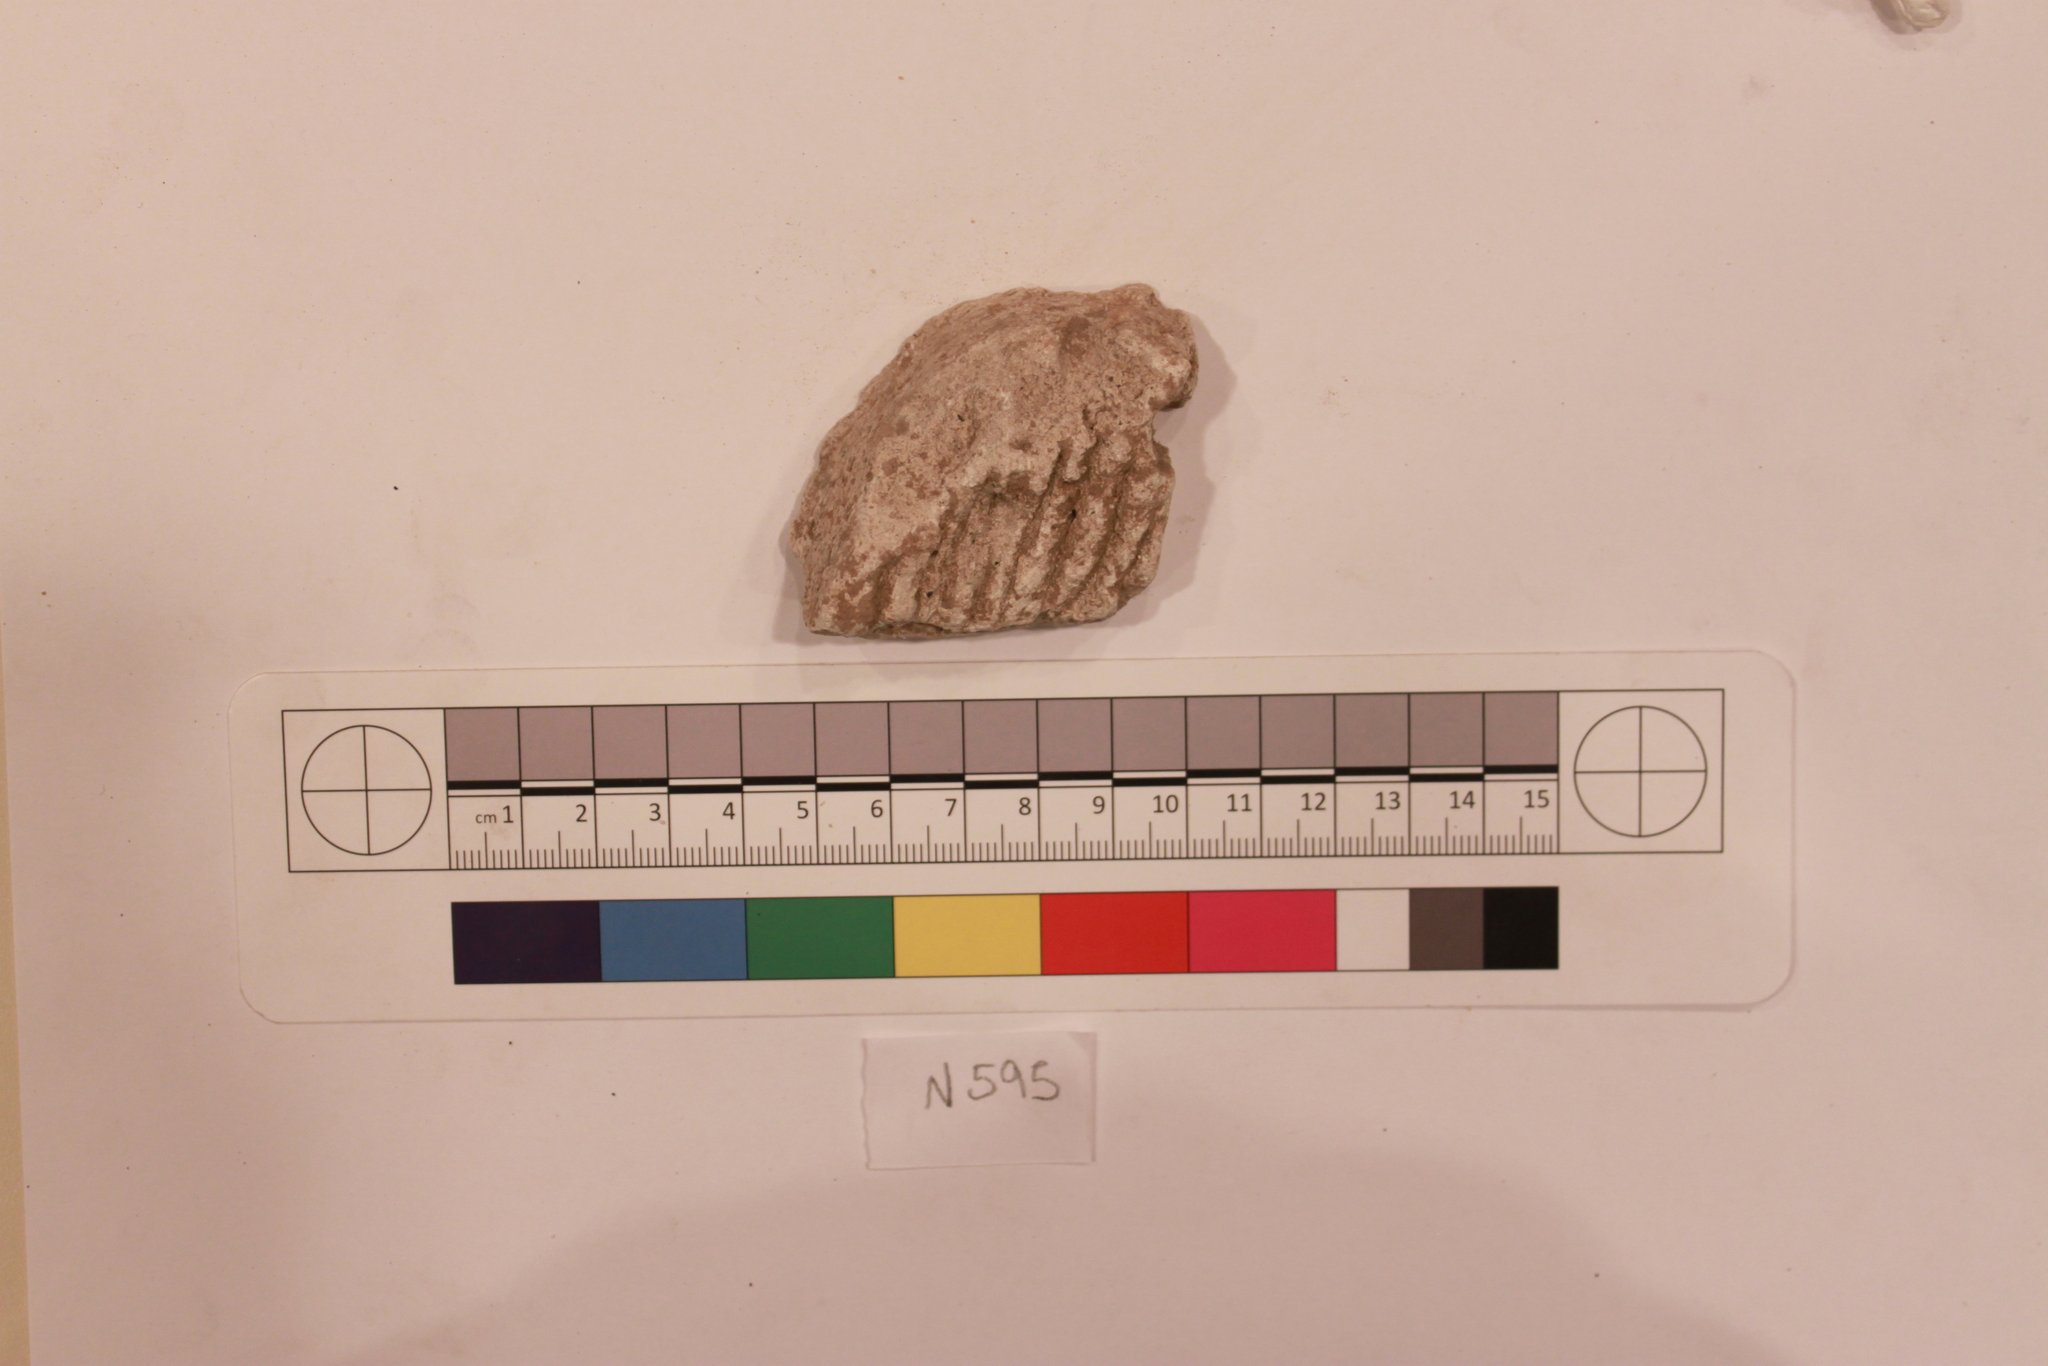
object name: fragment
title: Stucco Fragment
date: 701-1200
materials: plaster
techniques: carving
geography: iran